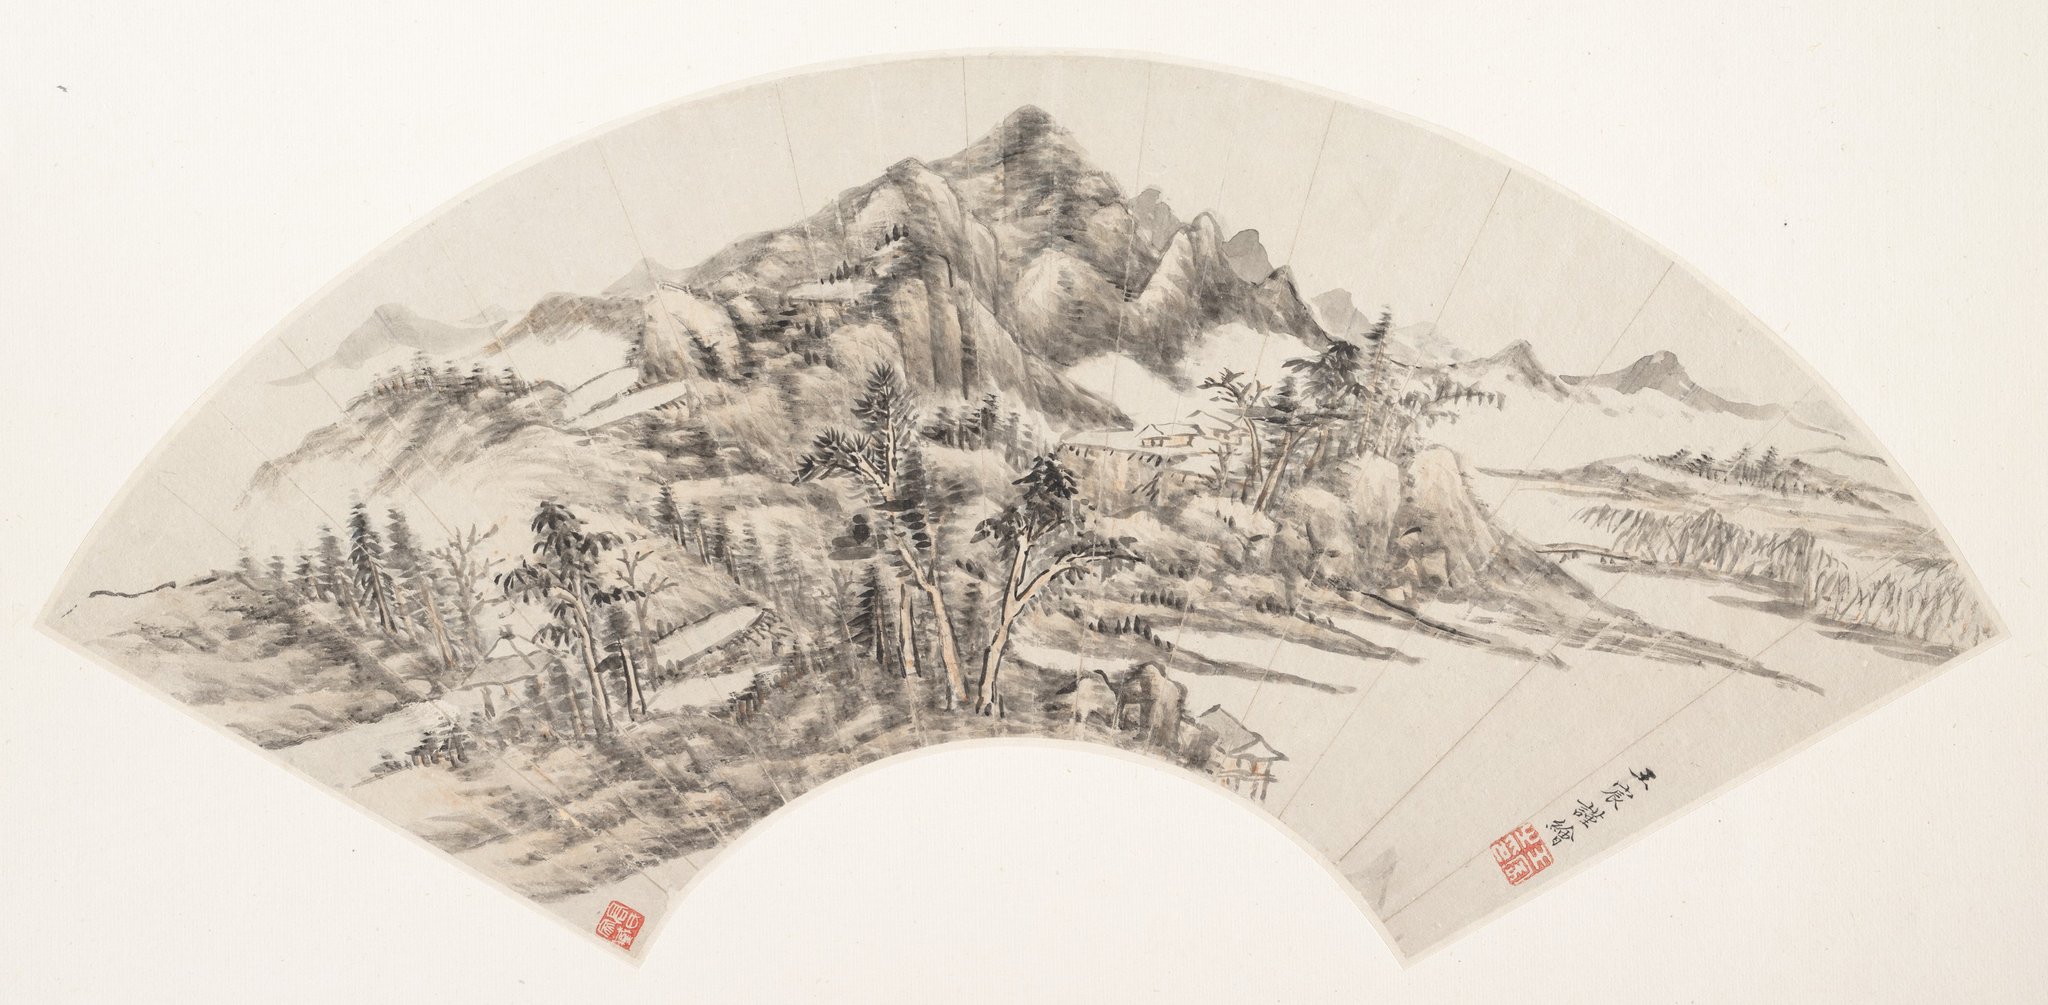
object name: folding fan mounted a an album leaf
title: Landscape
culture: chinese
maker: wang chen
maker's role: artist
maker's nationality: chinese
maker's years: 1720-1797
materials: ink, paper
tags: mountains,landscapes